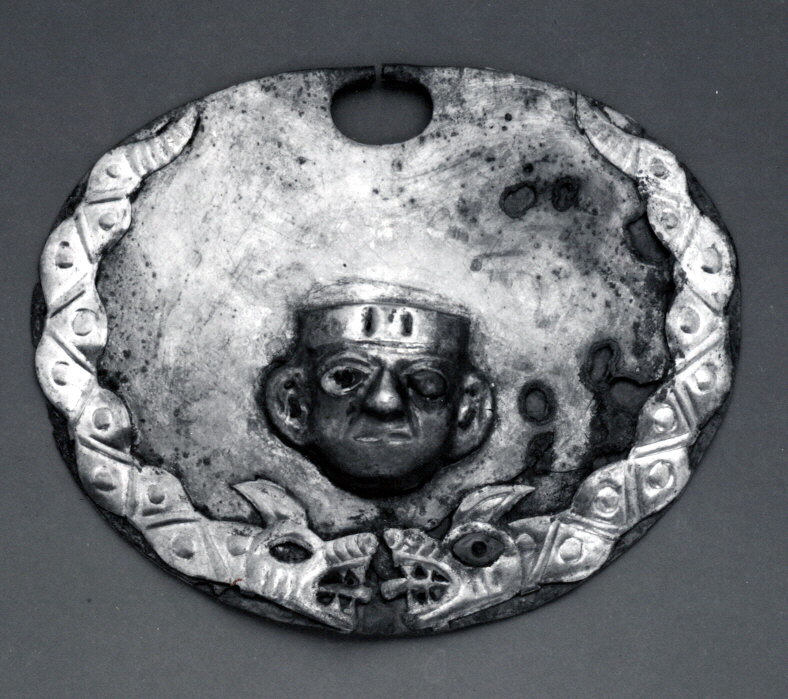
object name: nose ornament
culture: moche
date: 501-700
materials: gilt copper, gold, silver, stone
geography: peru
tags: faces